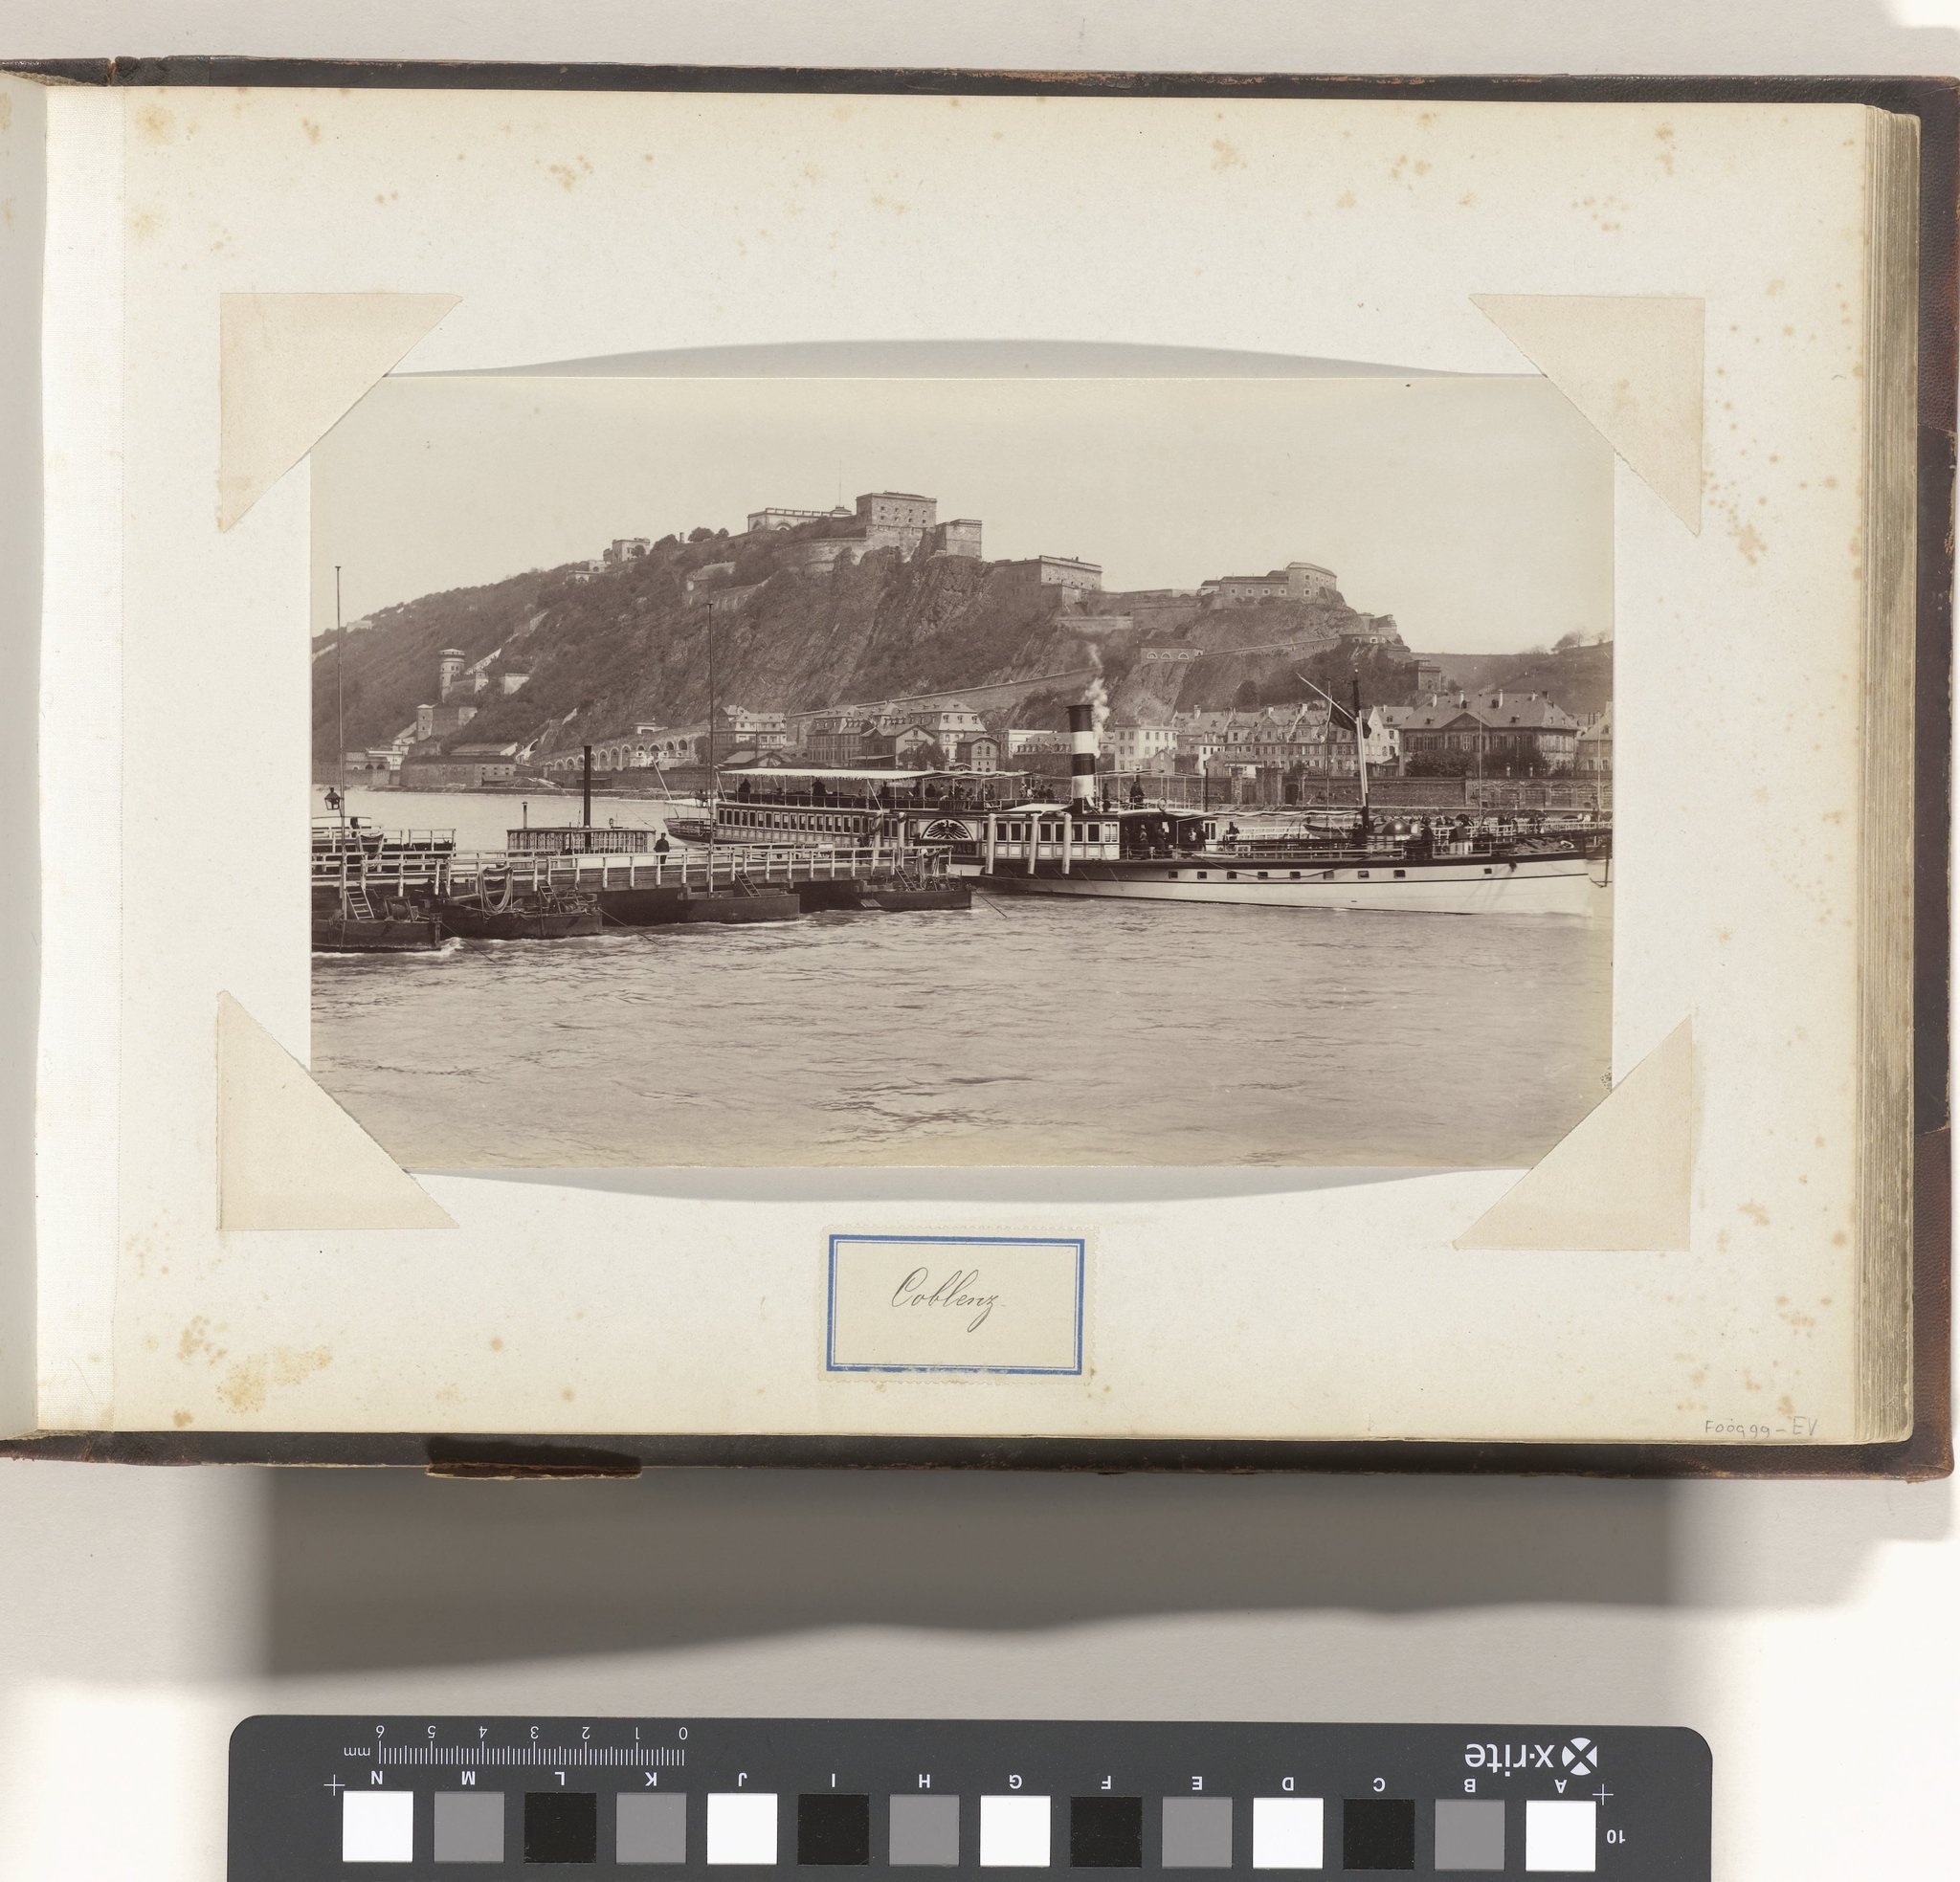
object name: photograph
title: Gezicht op fort Ehrenbreitstein en een pontonbrug bij Koblenz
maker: Anonymous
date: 1860-1900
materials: paper, photographic support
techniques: albumen print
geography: koblenz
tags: fortress, pontoon bridge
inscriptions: negative number: ‘24342’, inscription: ‘Ehrenbreitstein Bridge of Boats’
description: Onderdeel van Album met 191 foto's van een reis naar en door Zuid-Afrika.